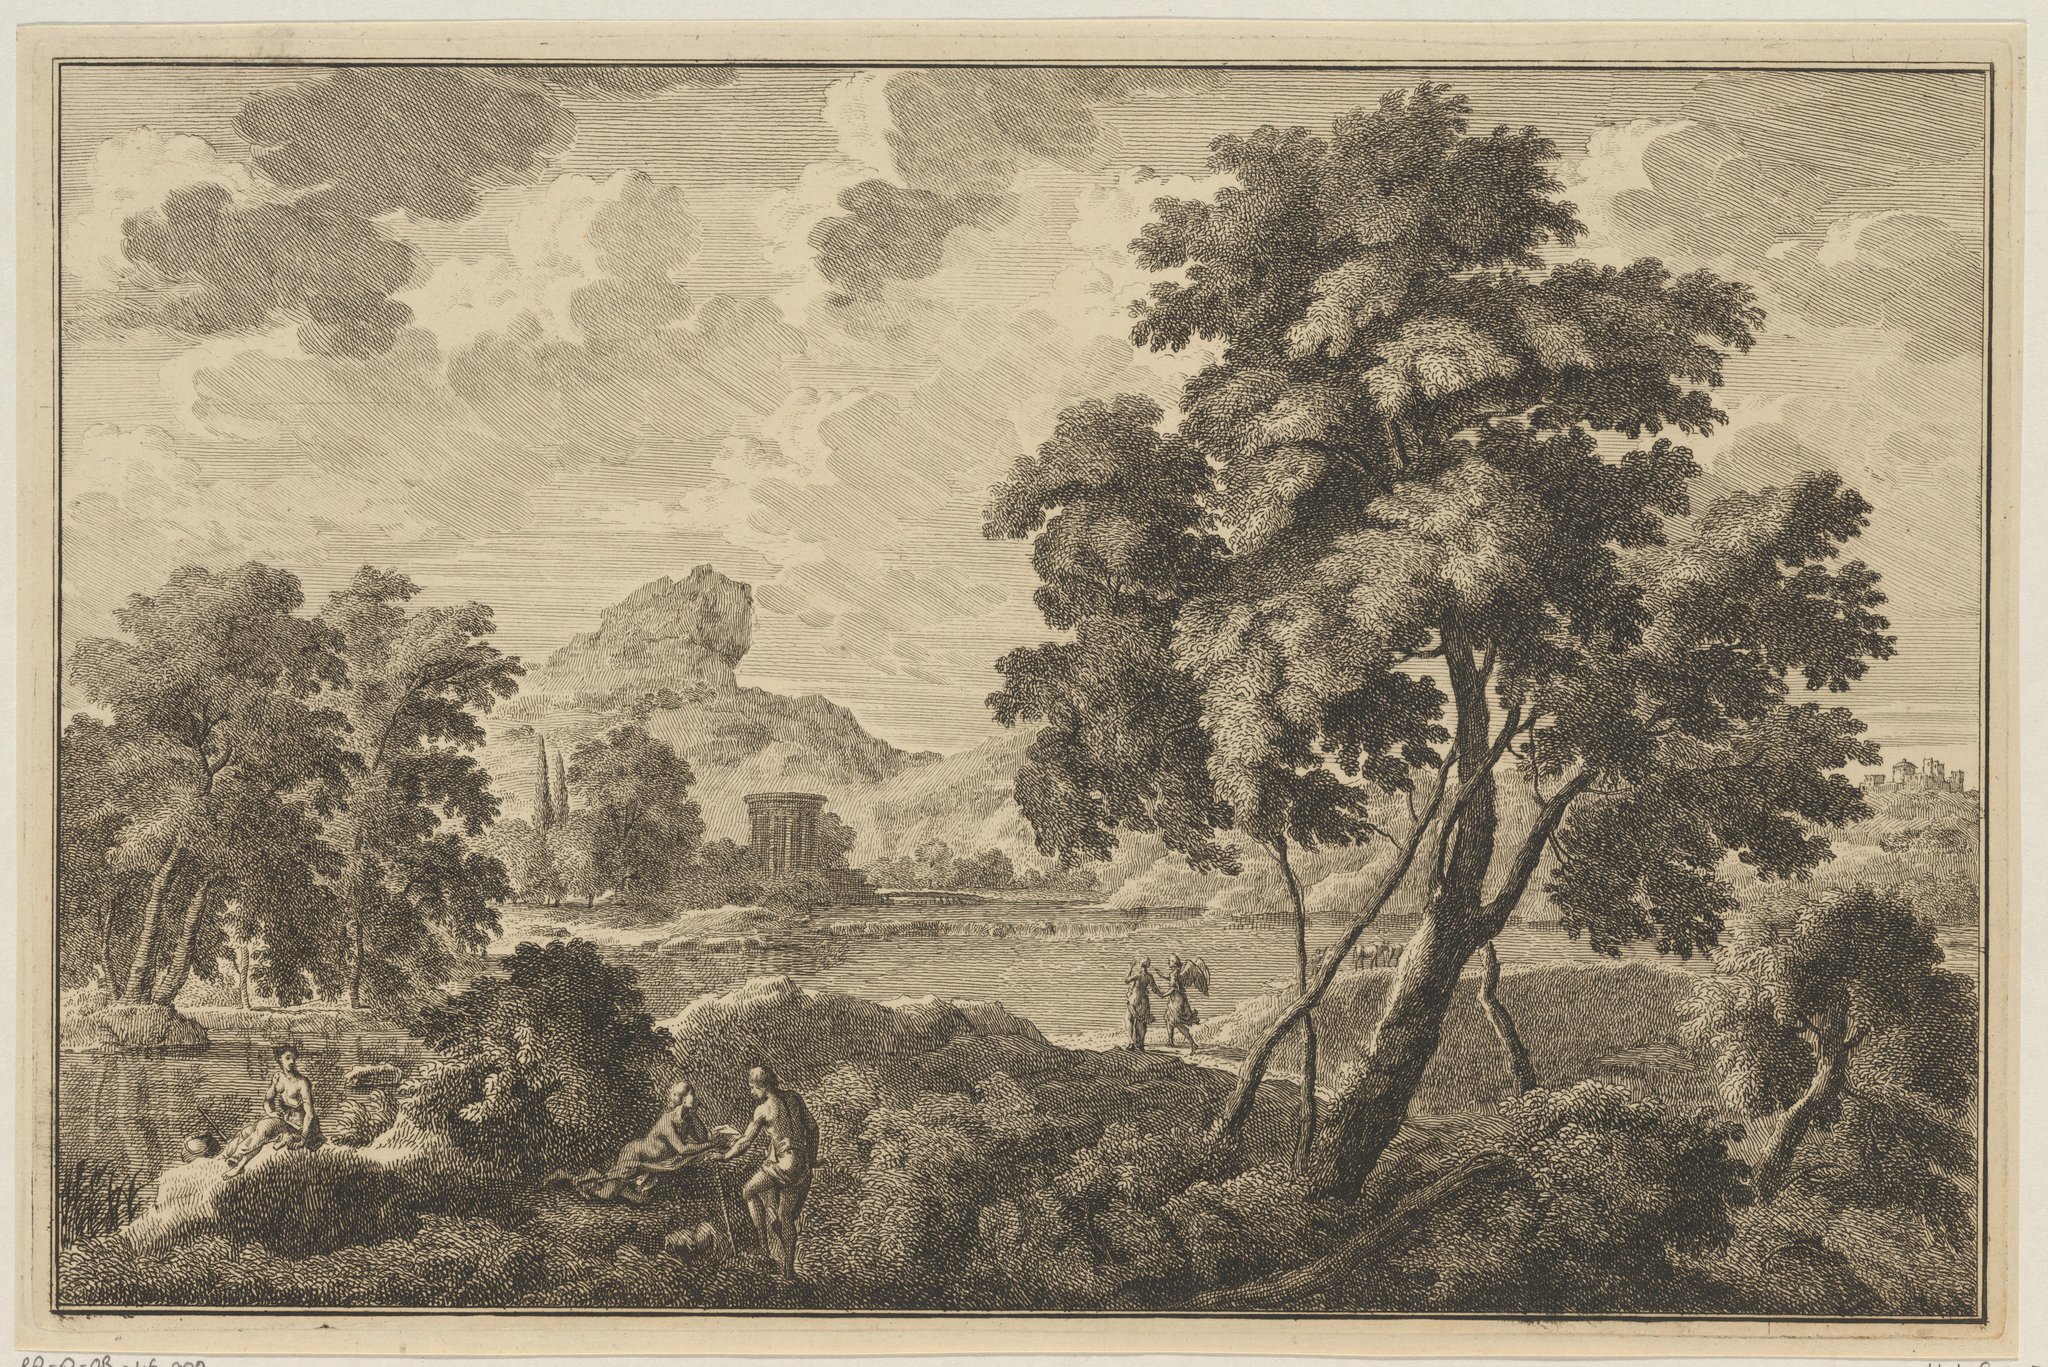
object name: print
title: Arcadisch rivierlandschap met engel en tempel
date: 1710-1747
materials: paper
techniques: etching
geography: amsterdam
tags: landscapes with waters, waterscapes, seascapes (in the temperate zone), temple, shrine ~ roman religion, angels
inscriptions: collector's mark: Lugt 240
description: Arcadisch rivierlandschap met links op de voorgrond drie figuren op de oever. Op de achtergrond staat een engel naast een vierde figuur, aan de overkant van de rivier ligt een tempel. De prent maakt mogelijk deel uit van een 40-delige serie prenten met voorstellingen van Italiaanse en Duitse landschappen.